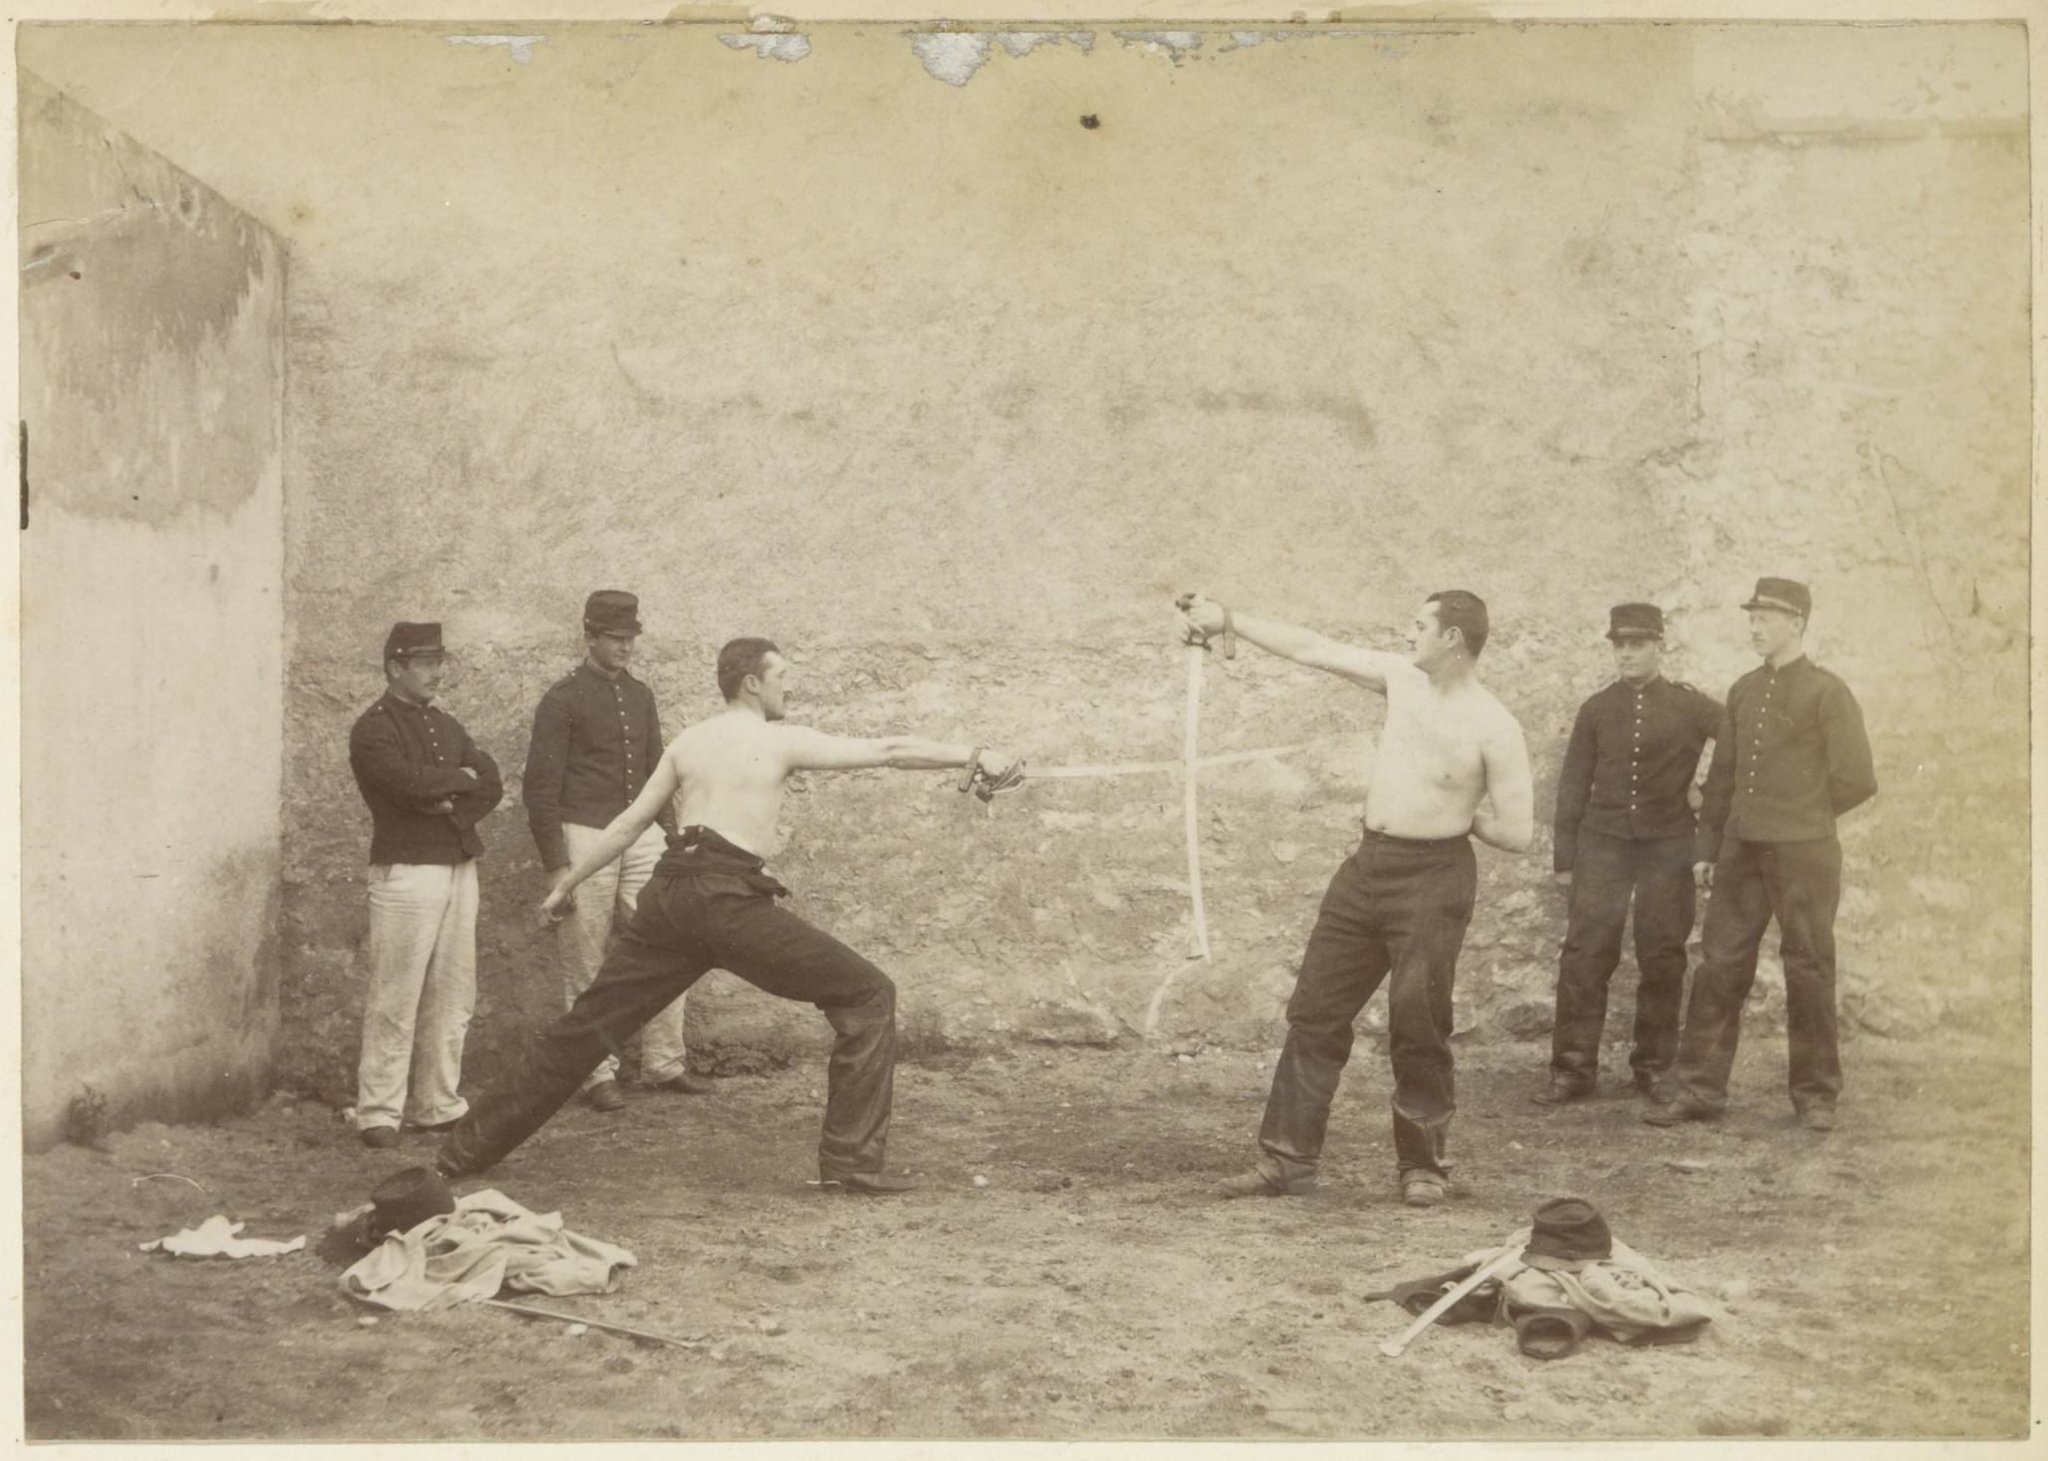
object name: photograph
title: Militairen met sabels bij een kazerne in Frankrijk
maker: Anonymous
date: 1900-1910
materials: paper, photographic support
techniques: albumen print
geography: france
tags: hacking and thrusting weapons (with name), land forces, (military) uniforms, france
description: Onderdeel van Fotoalbum van een Franse amateurfotograaf met opnames van een familie, distilleerderij Delizy & Doistau Fils, het leger en bezienswaardigheden in Frankrijk.